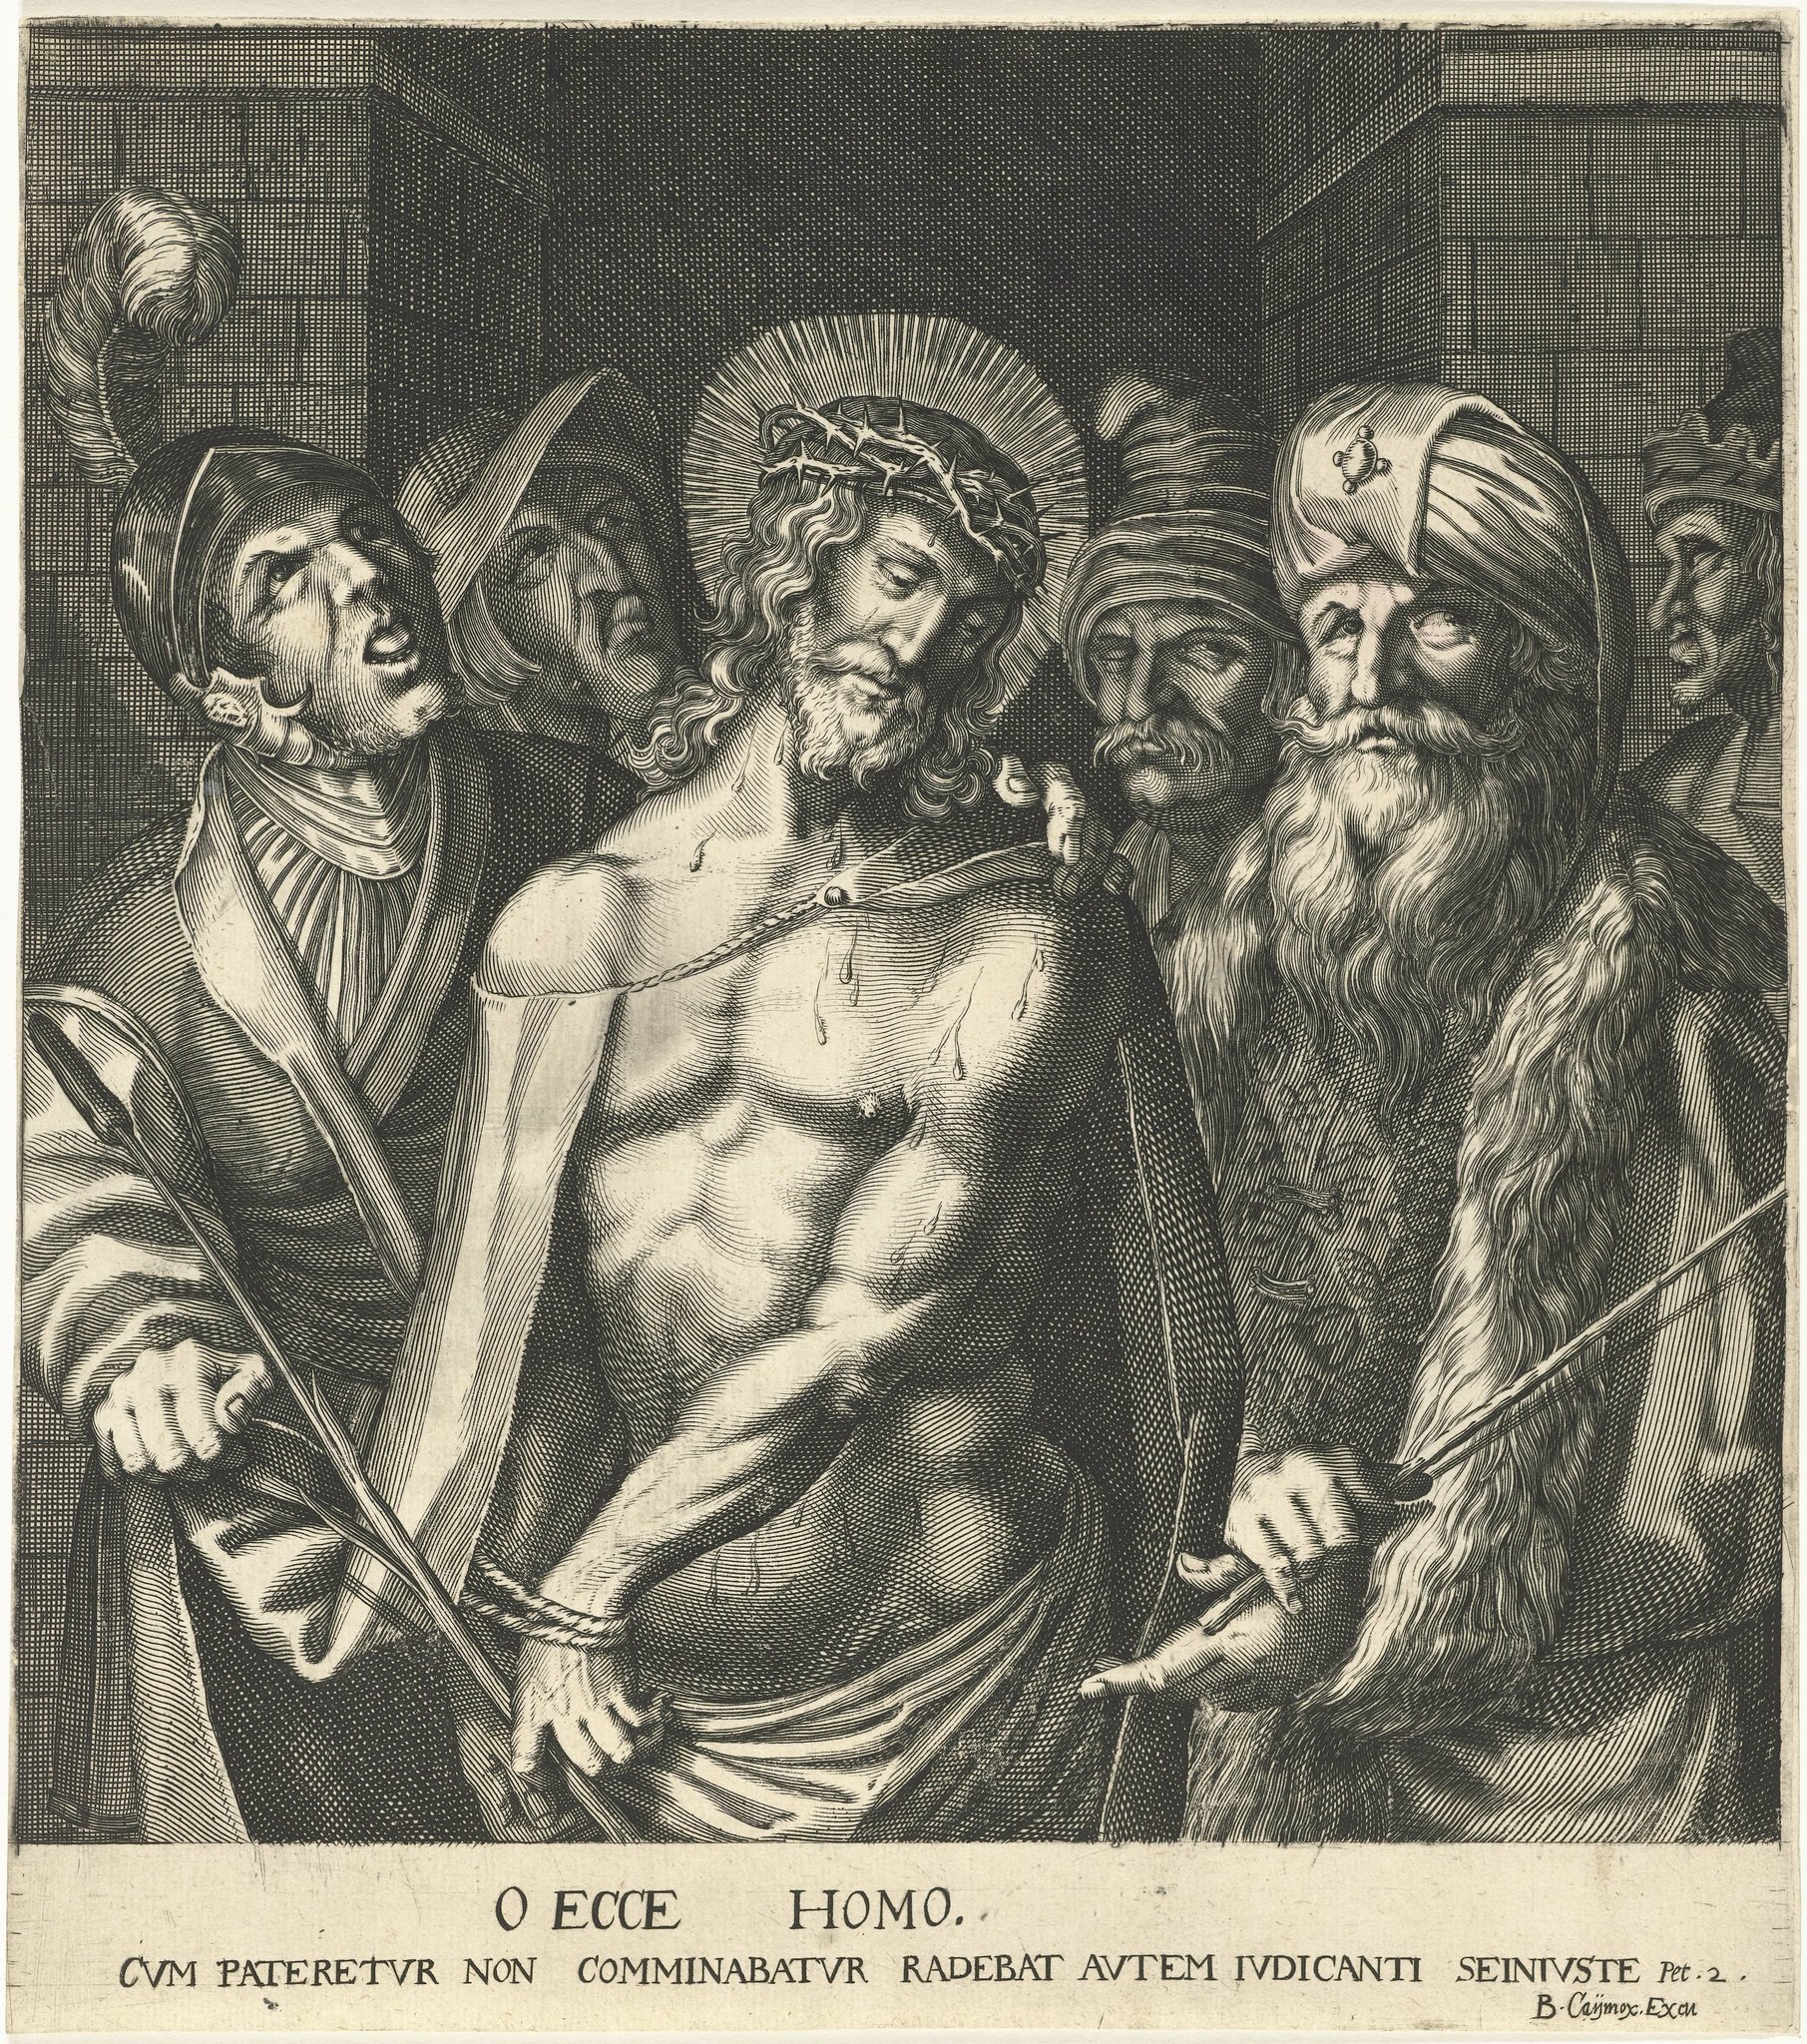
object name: print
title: O Ecce Homo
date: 1591-1613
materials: paper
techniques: engraving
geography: nuremberg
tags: christ alone (also called 'ecce homo')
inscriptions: collector's mark: Lugt 2228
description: Christus is in gevangenschap. Zijn handen zijn vastgebonden en hij draagt al de doornenkroon. Naast hem staat Pilatus met een tulband en een bontmantel. De soldaat die Christus wegvoert trekt een grimas.